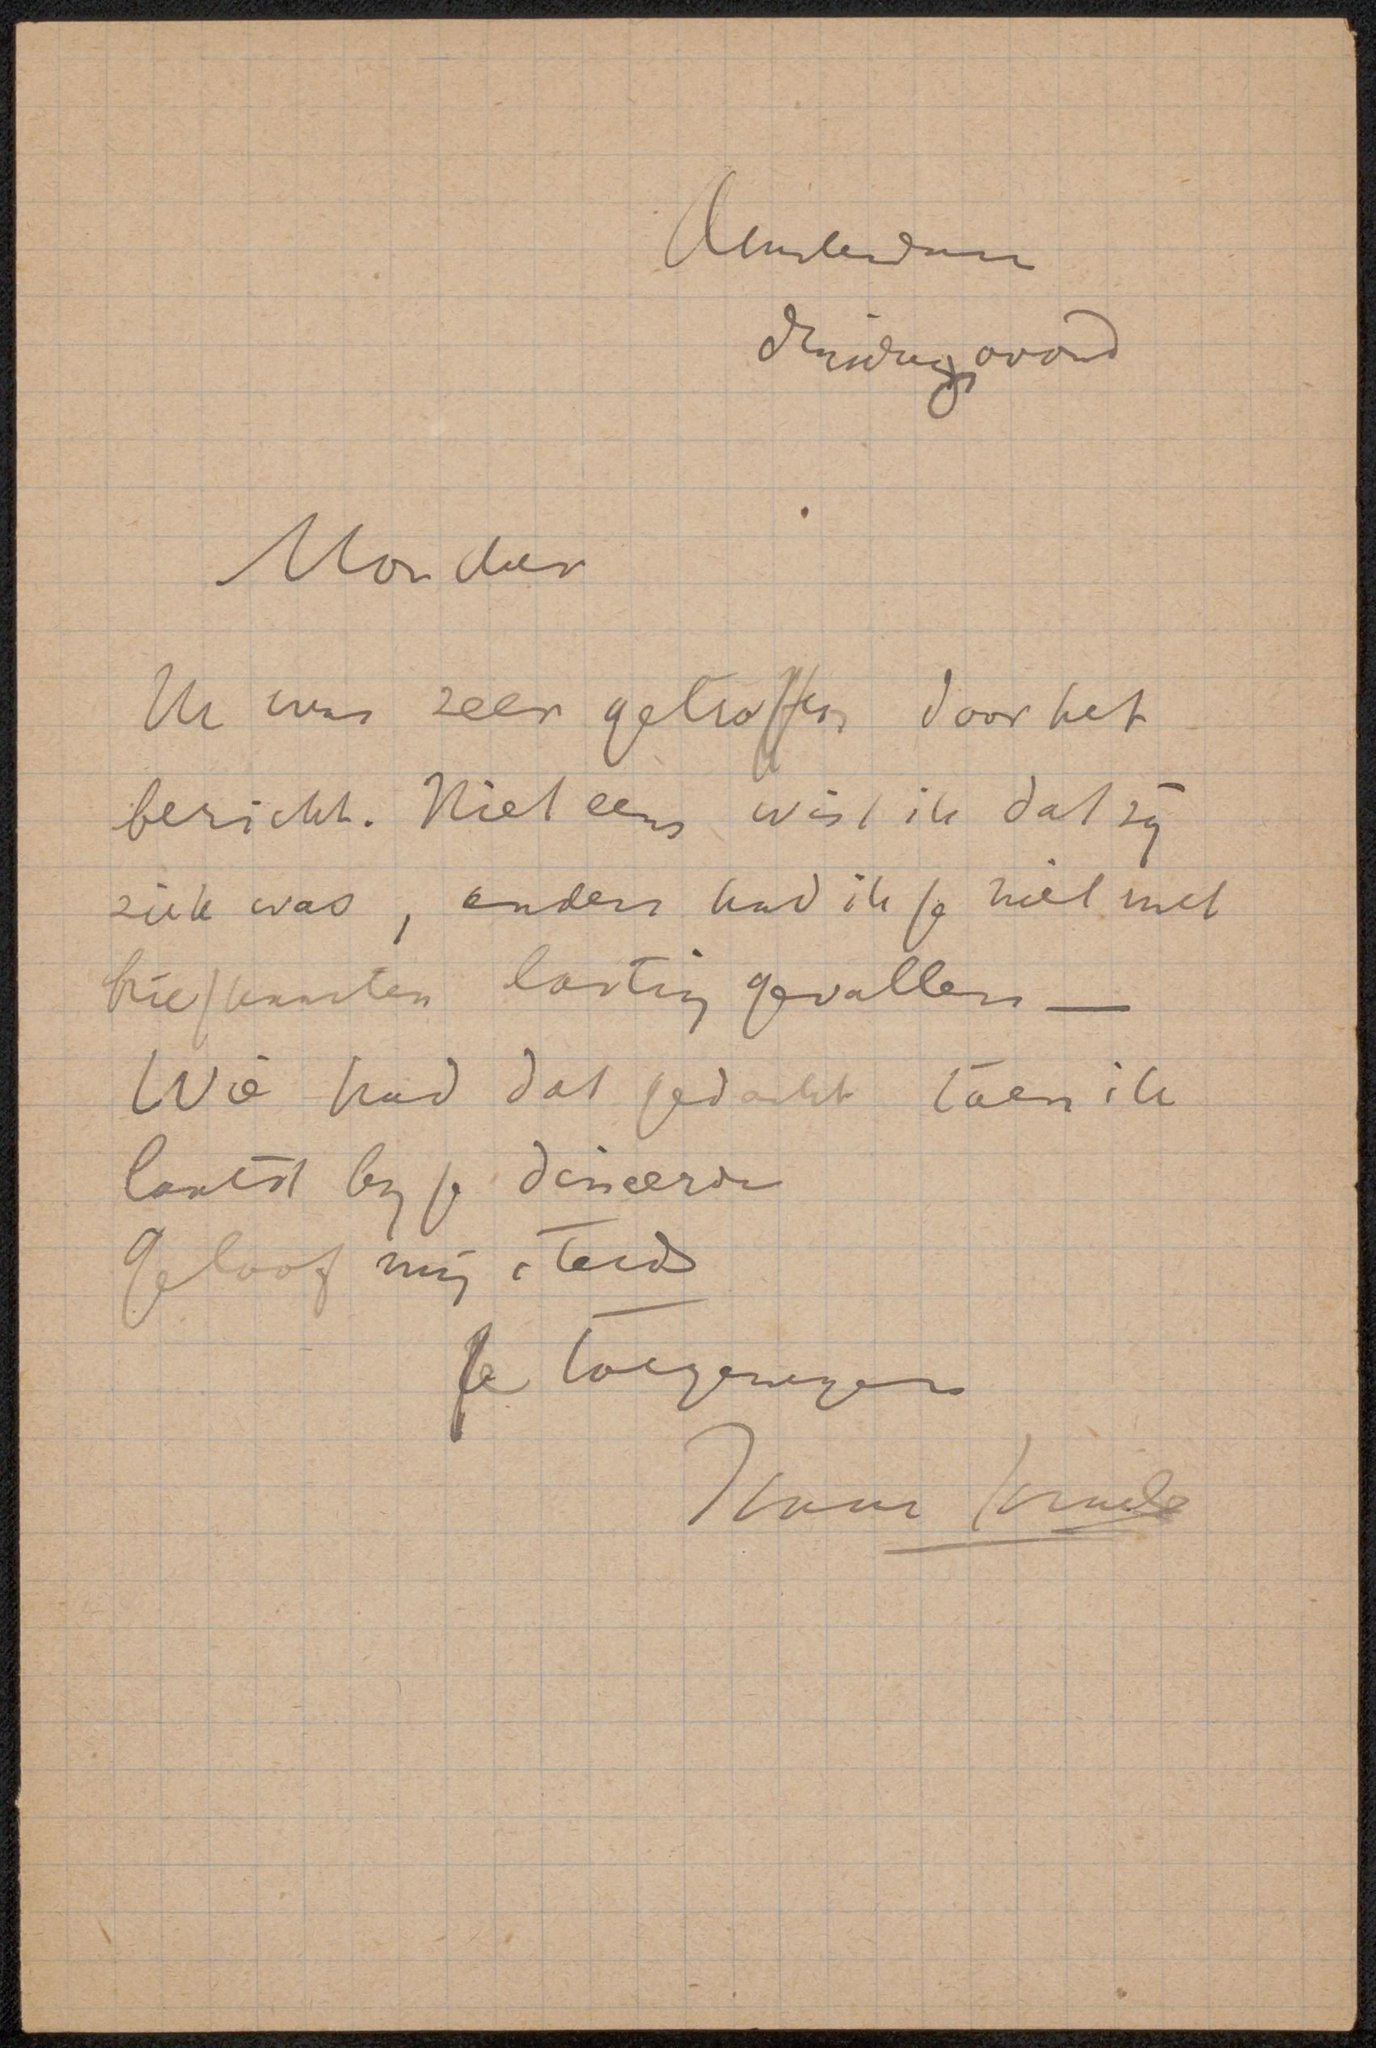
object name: letter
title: Brief aan Philip Zilcken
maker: isaac israels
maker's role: draughtsman, painter, print maker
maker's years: 1865-1934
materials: ink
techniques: pen, writing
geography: amsterdam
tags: helène lambertine hauzeur, philip zilcken, passions, emotions, affections